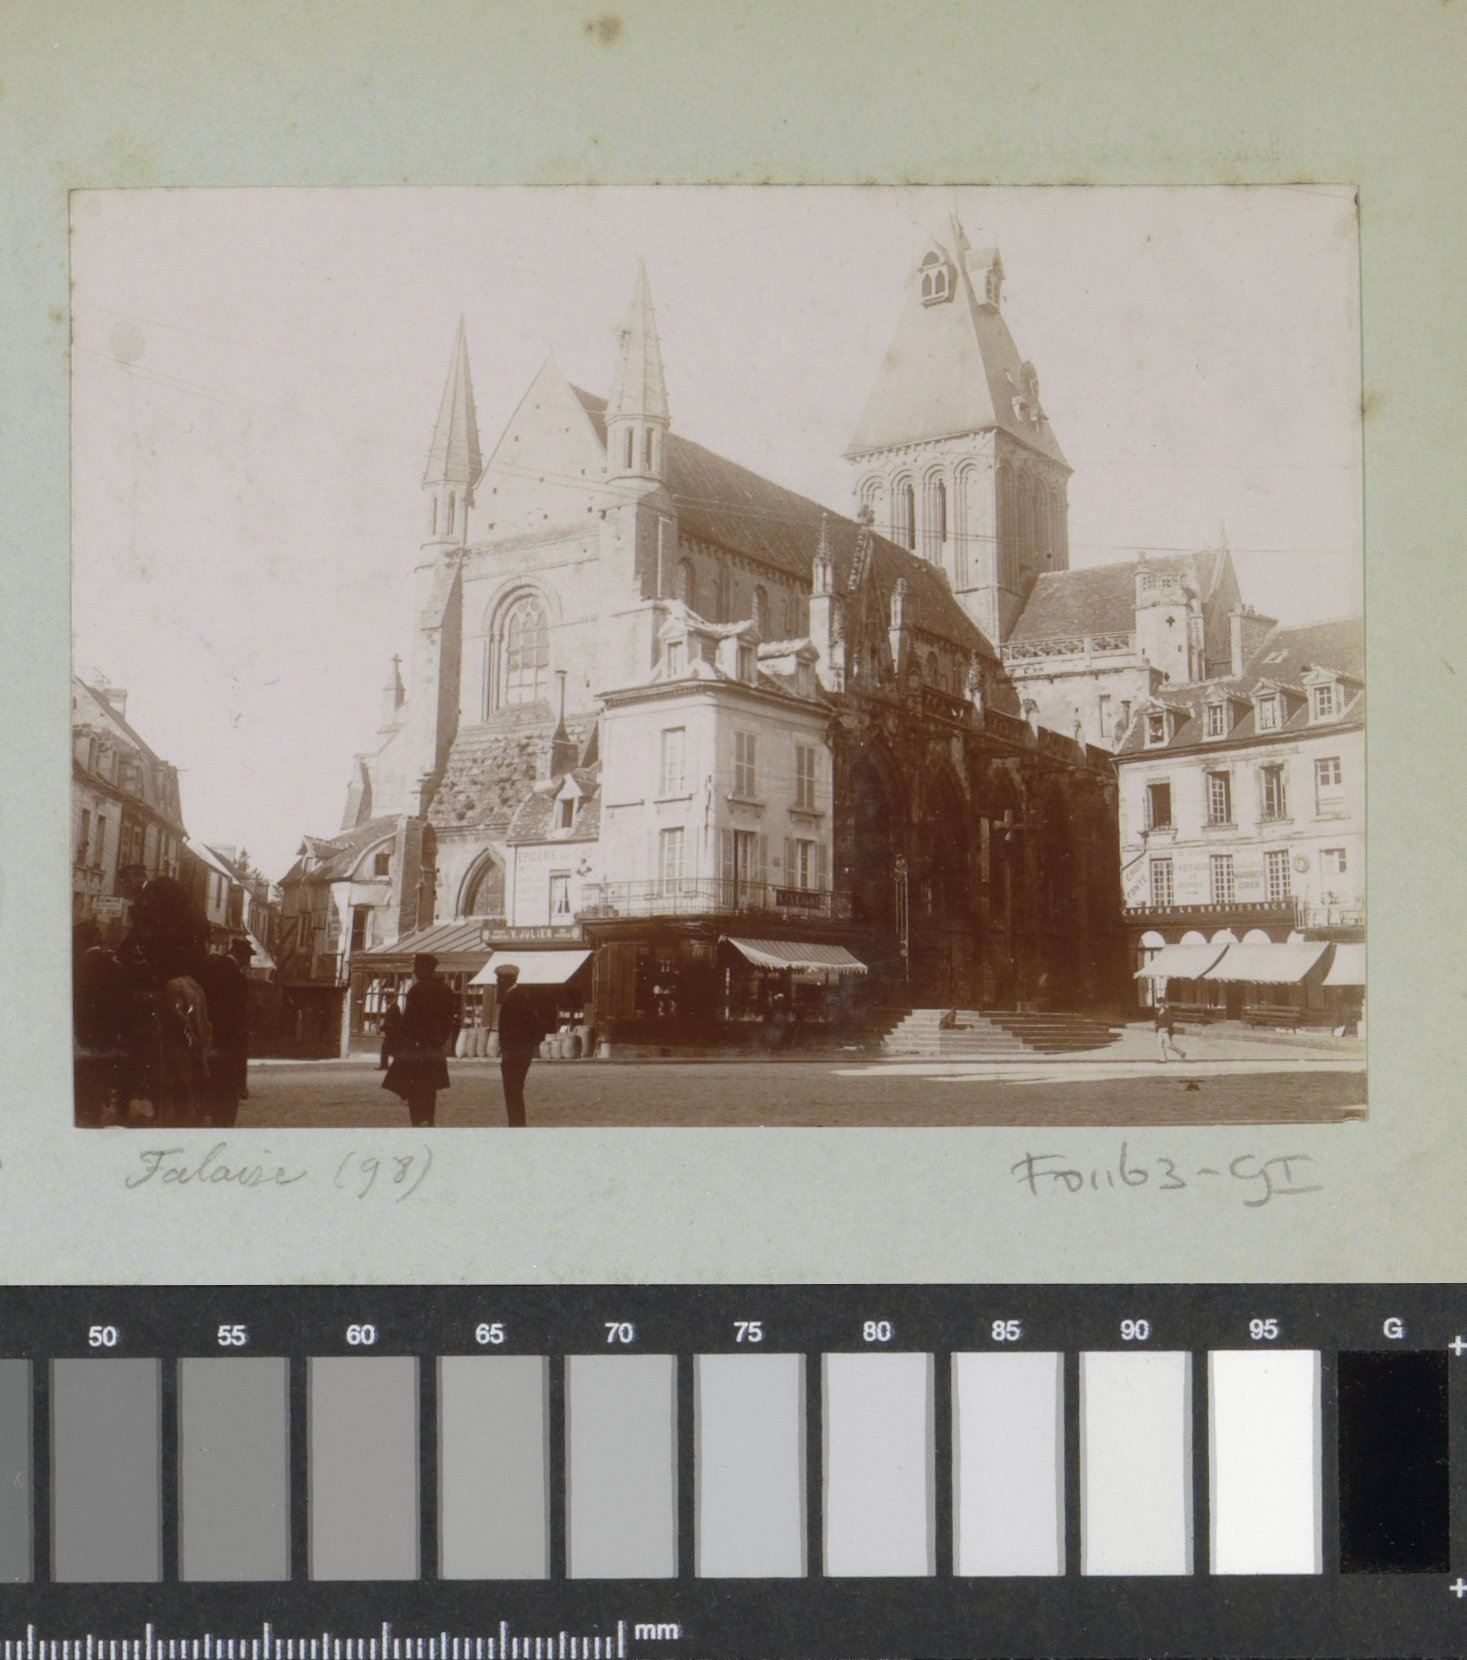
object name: photograph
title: Gezicht op een plein in Falaise met op de achtergrond L'église Saint-Gervais-Saint-Protais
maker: delizy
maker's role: manufacturer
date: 1898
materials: paper, photographic support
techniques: gelatin silver print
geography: falaise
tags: church (exterior), square, place, circus, etc. (+ city(-scape) with figures, staffage)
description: Onderdeel van Fotoalbum van een Franse amateurfotograaf met opnames van uitstapjes in Frankrijk, Spanje, België, Luxemburg en Nederland, de eerste automobielen en autoraces.